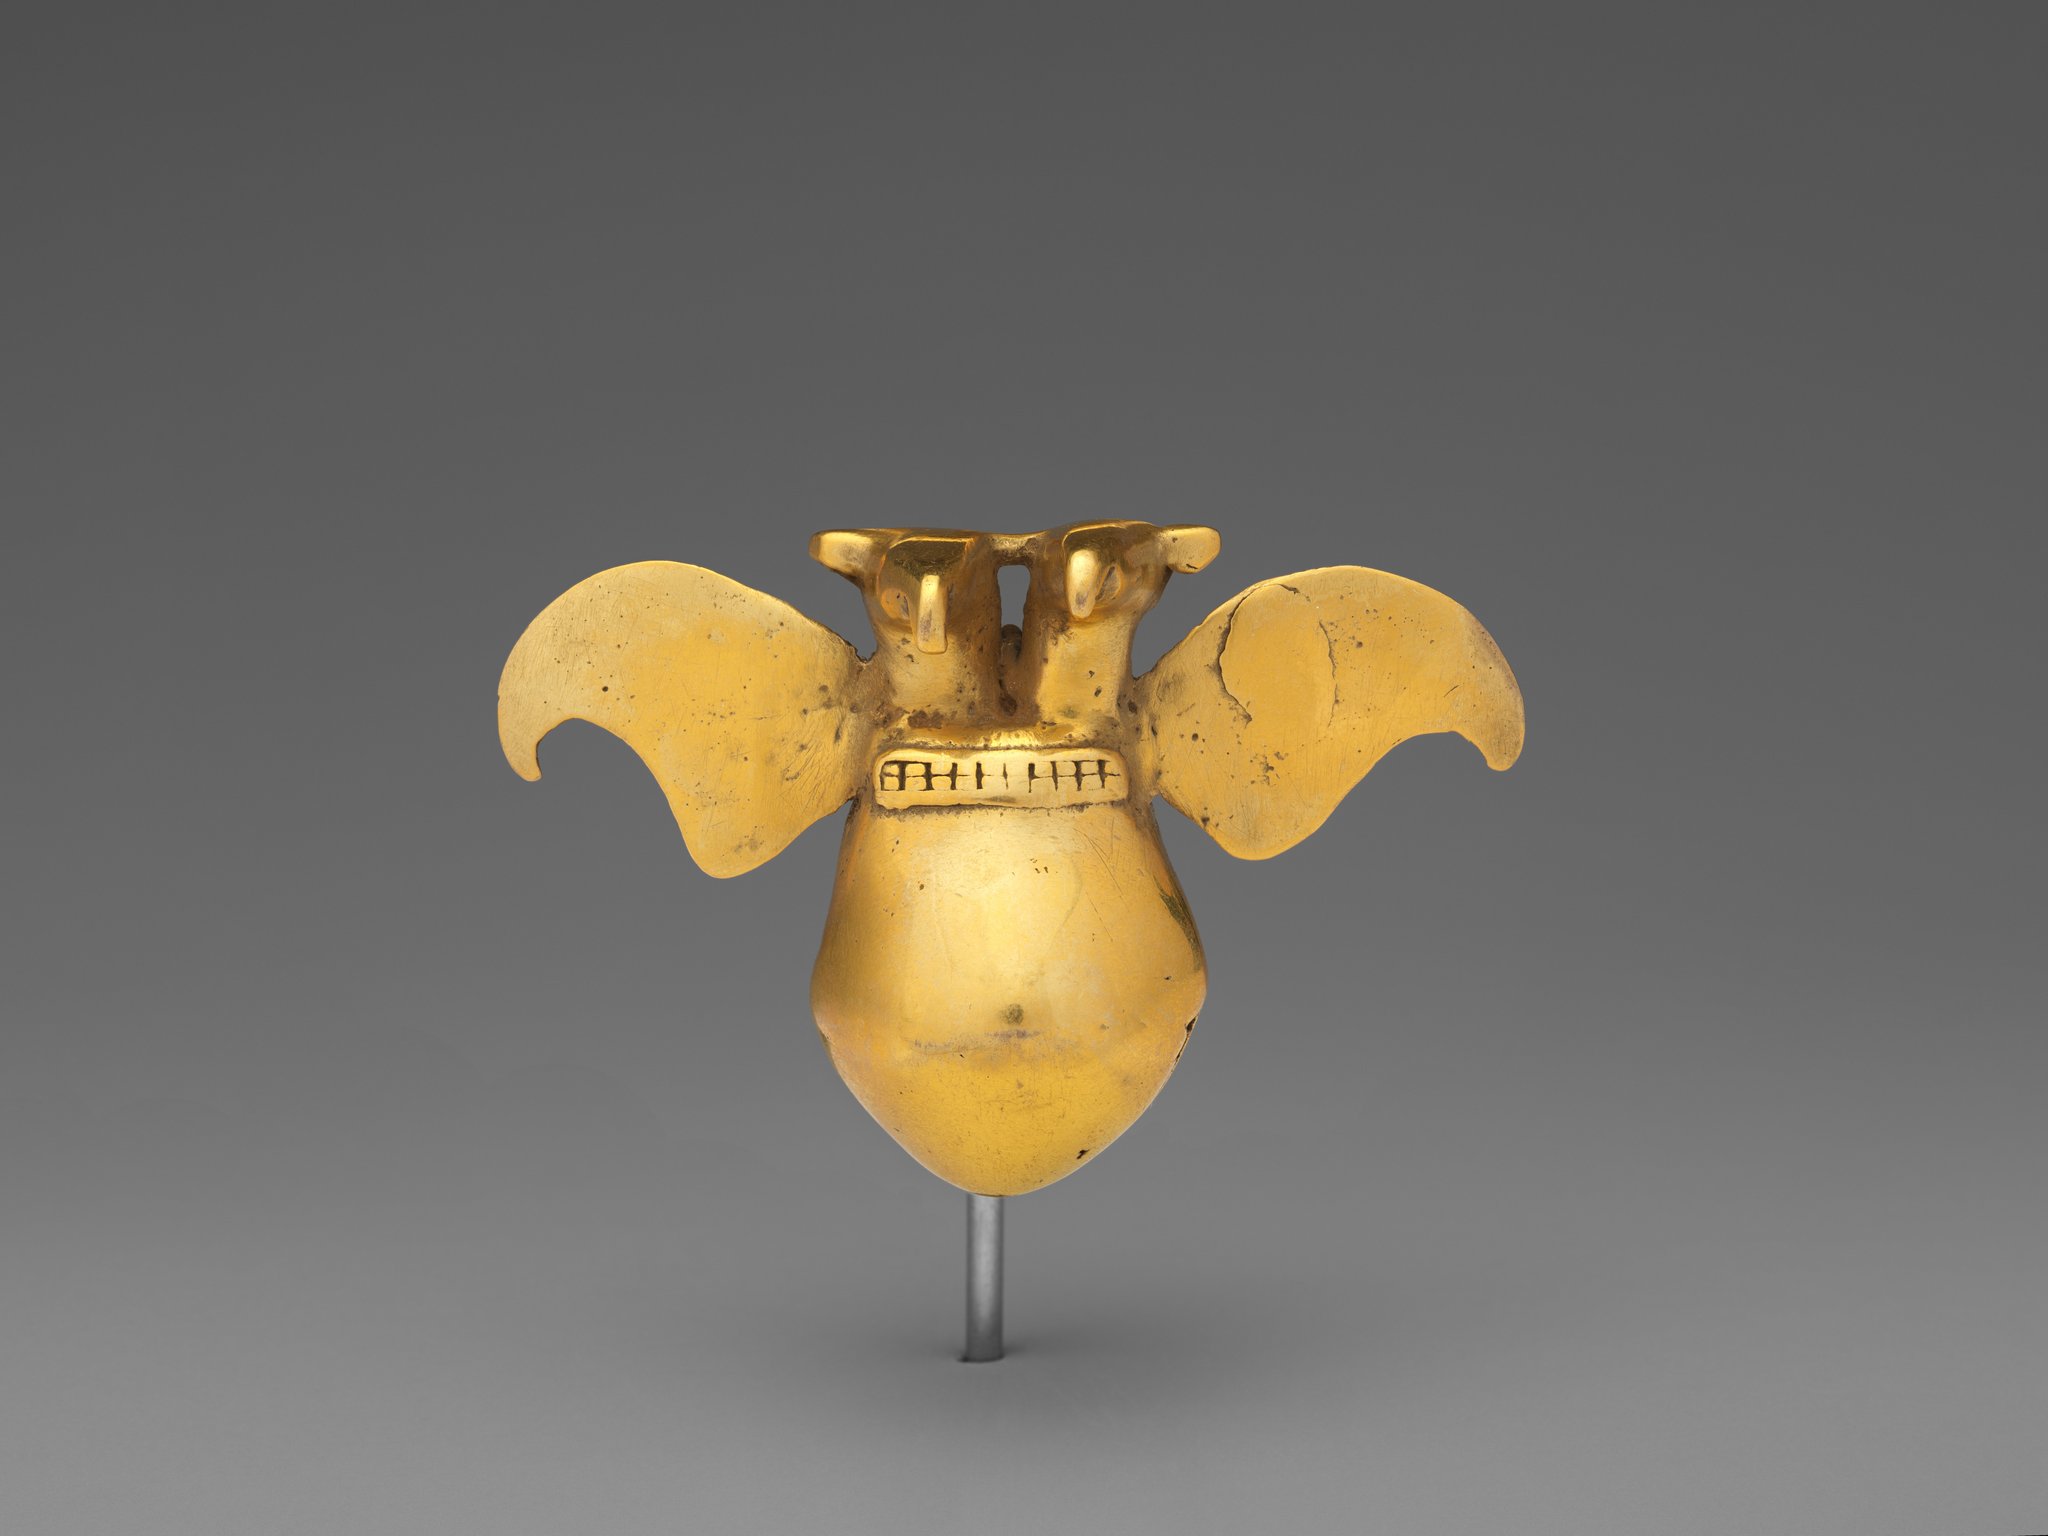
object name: bell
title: Eagle pendant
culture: veraguas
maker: veraguas artist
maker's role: artist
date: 700-1550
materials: gold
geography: panama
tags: eagles